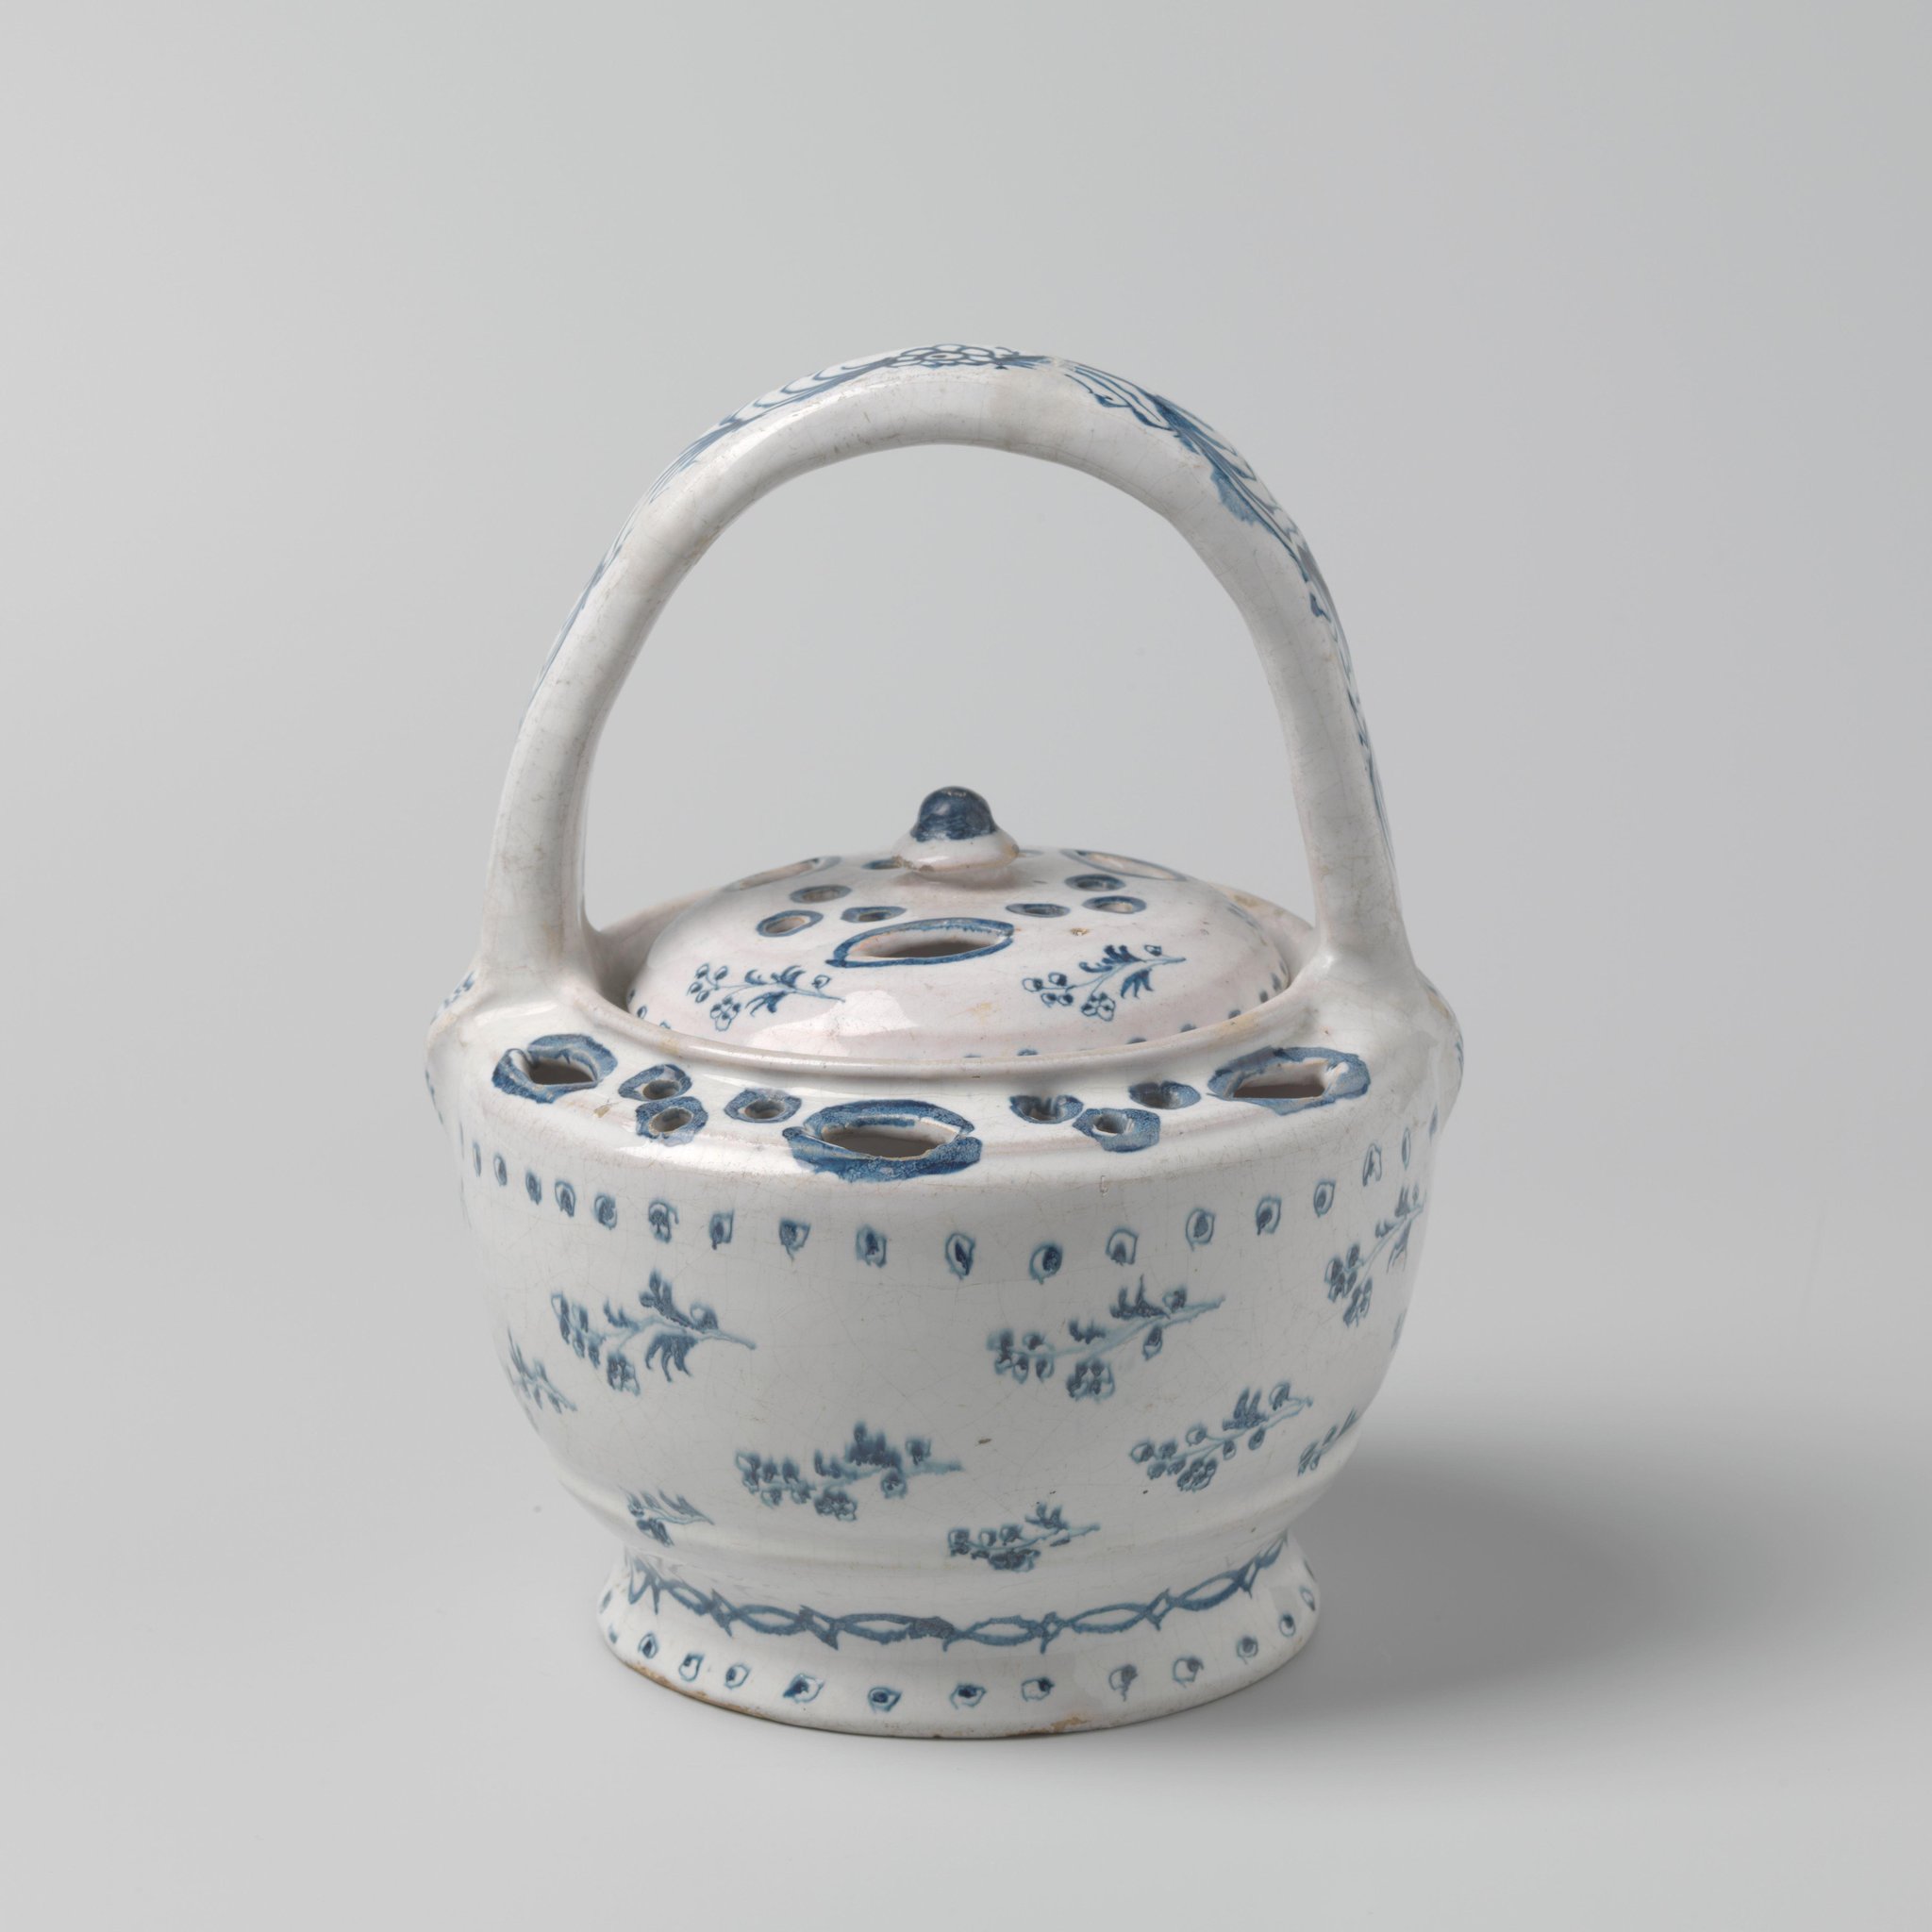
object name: lid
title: Deksel van terrine, beschilderd met strooibloemen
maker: Anonymous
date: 1775-1820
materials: faience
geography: brussels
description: Terrine van faience. Blauw beschilderd met strooibloemen.